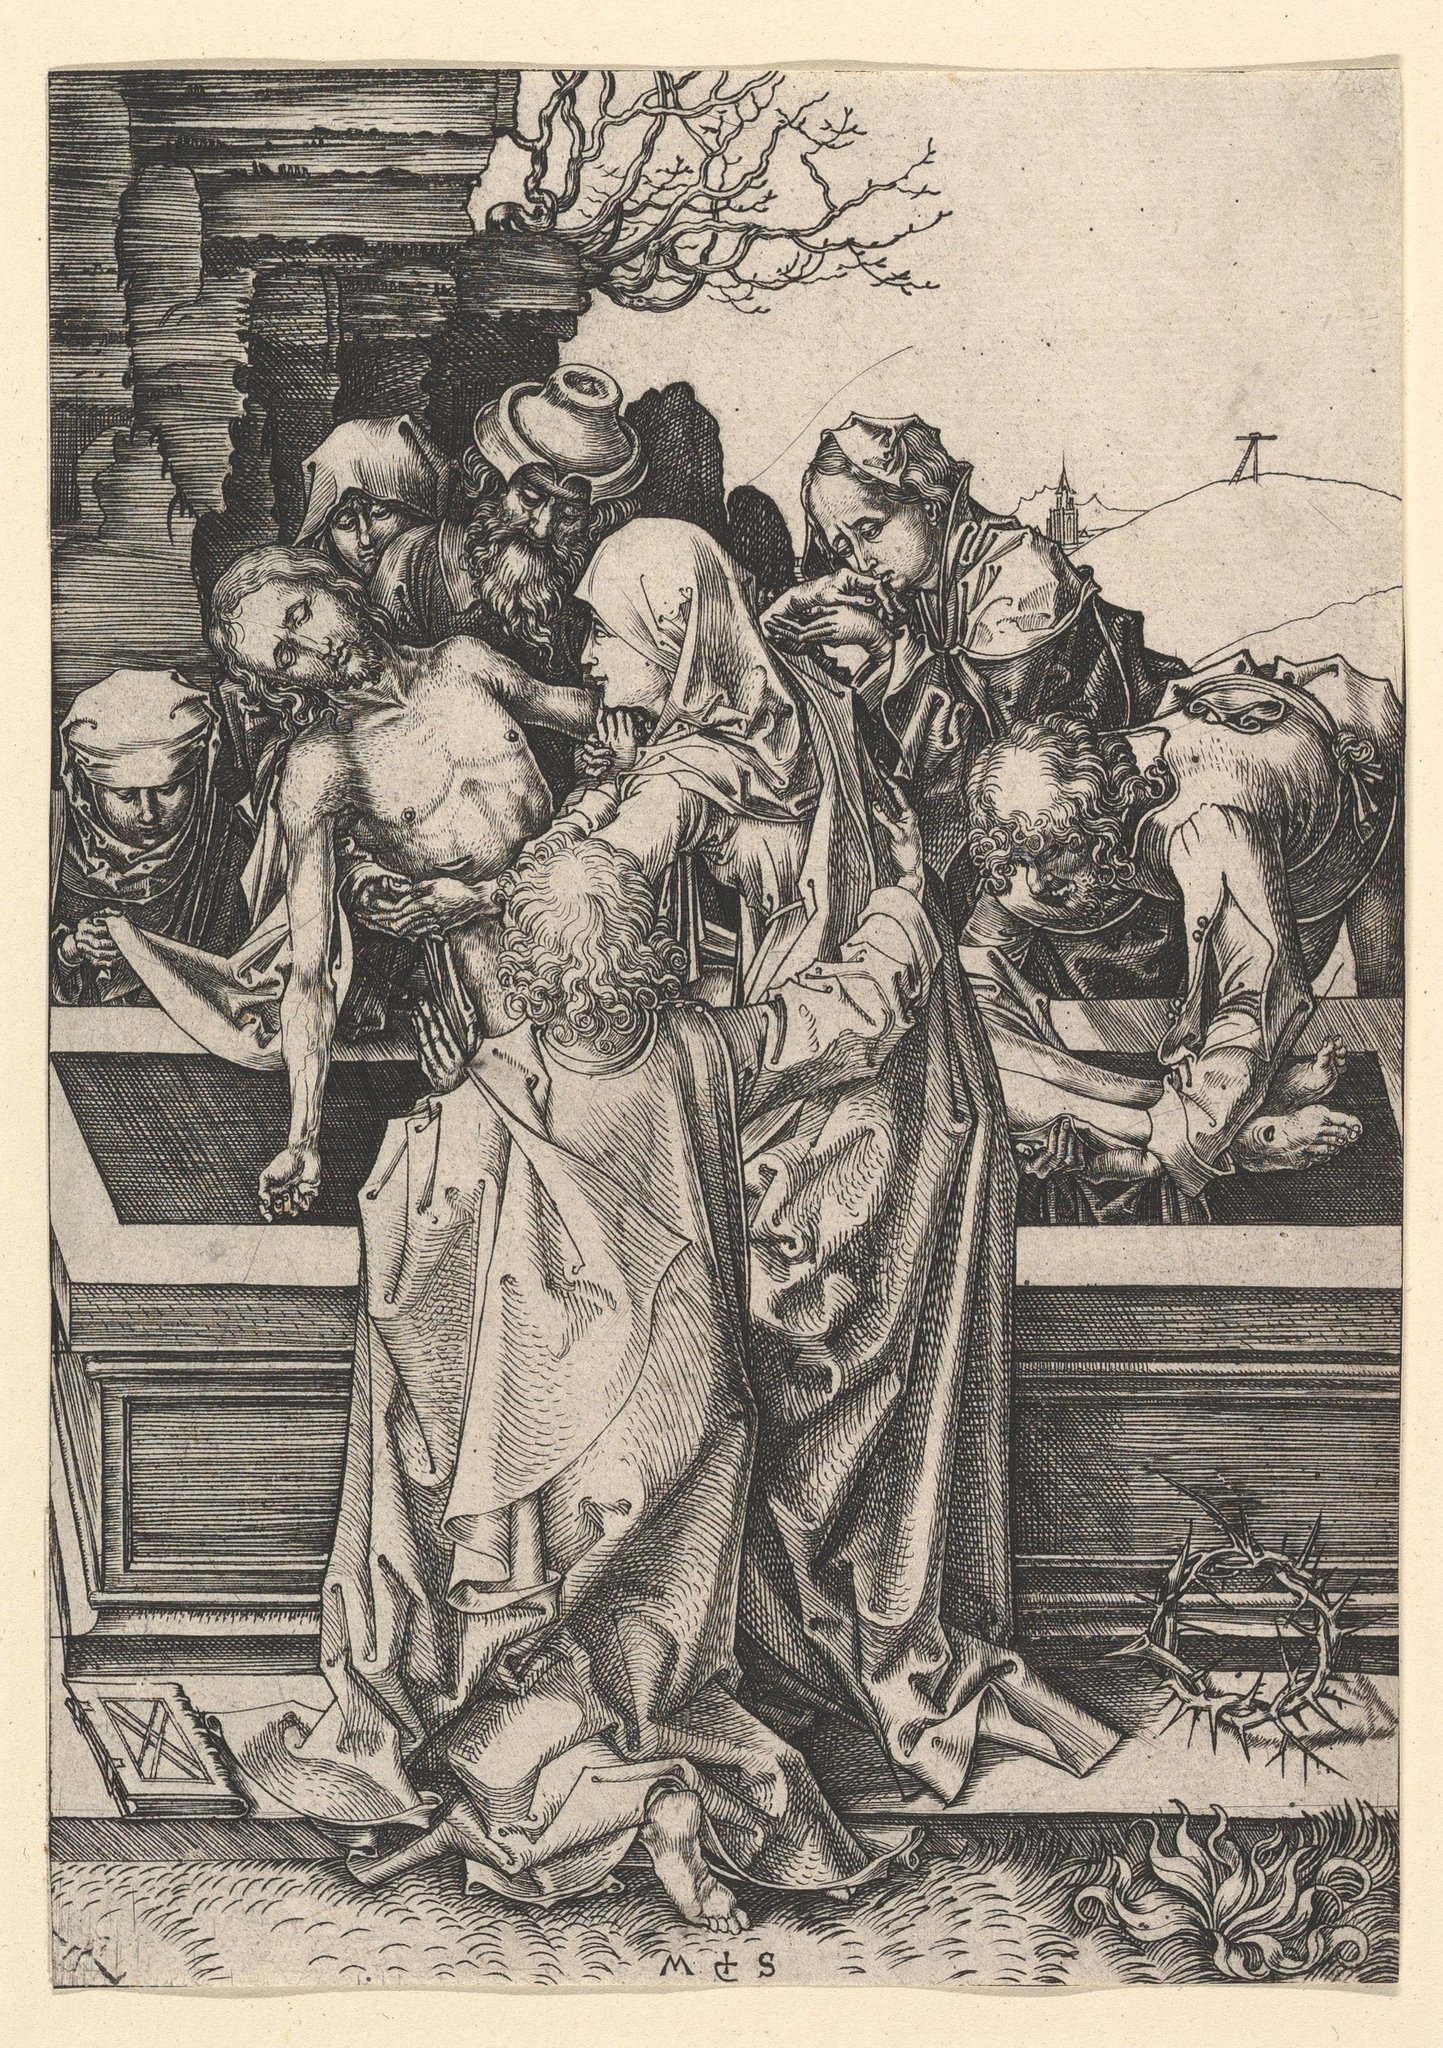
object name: print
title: The Entombment of Christ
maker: martin schongauer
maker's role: artist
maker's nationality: german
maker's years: 1430-1491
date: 1470-1482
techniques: engraving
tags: men,christ,virgin mary,entombment